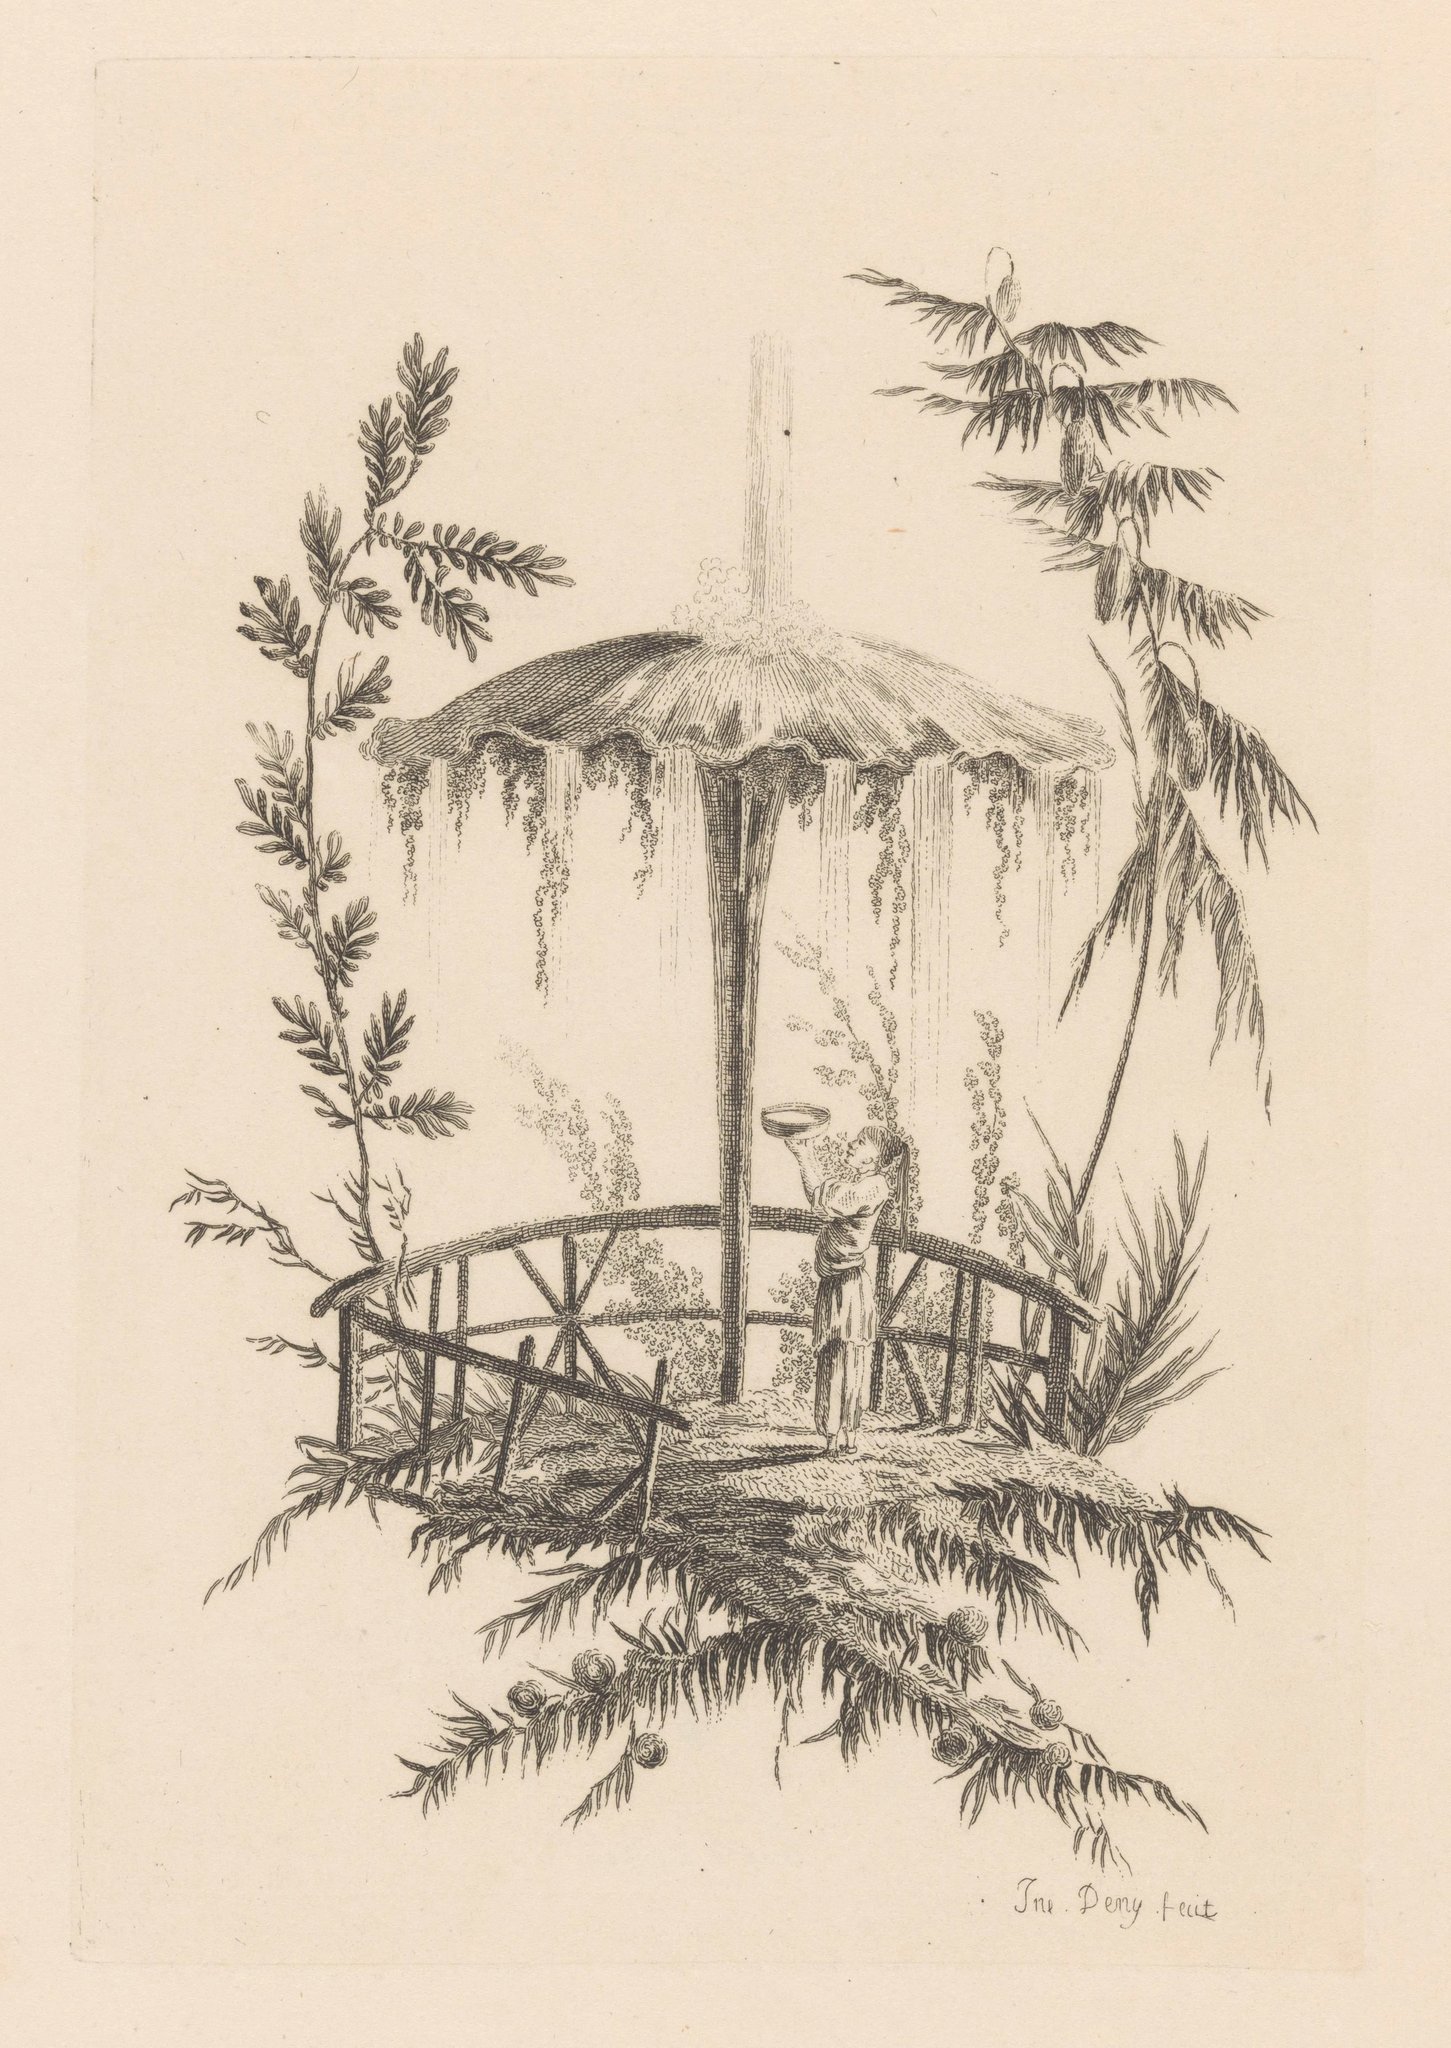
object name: ornament print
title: Recueil Des Fontaines, Chinoises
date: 1770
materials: paper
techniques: etching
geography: paris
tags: landscapes, ornamental fountain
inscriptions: collector's mark: Lugt 2760, collector's mark: Lugt 2228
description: In een landschap met een hek staat een figuur met een schaal onder een fontein.